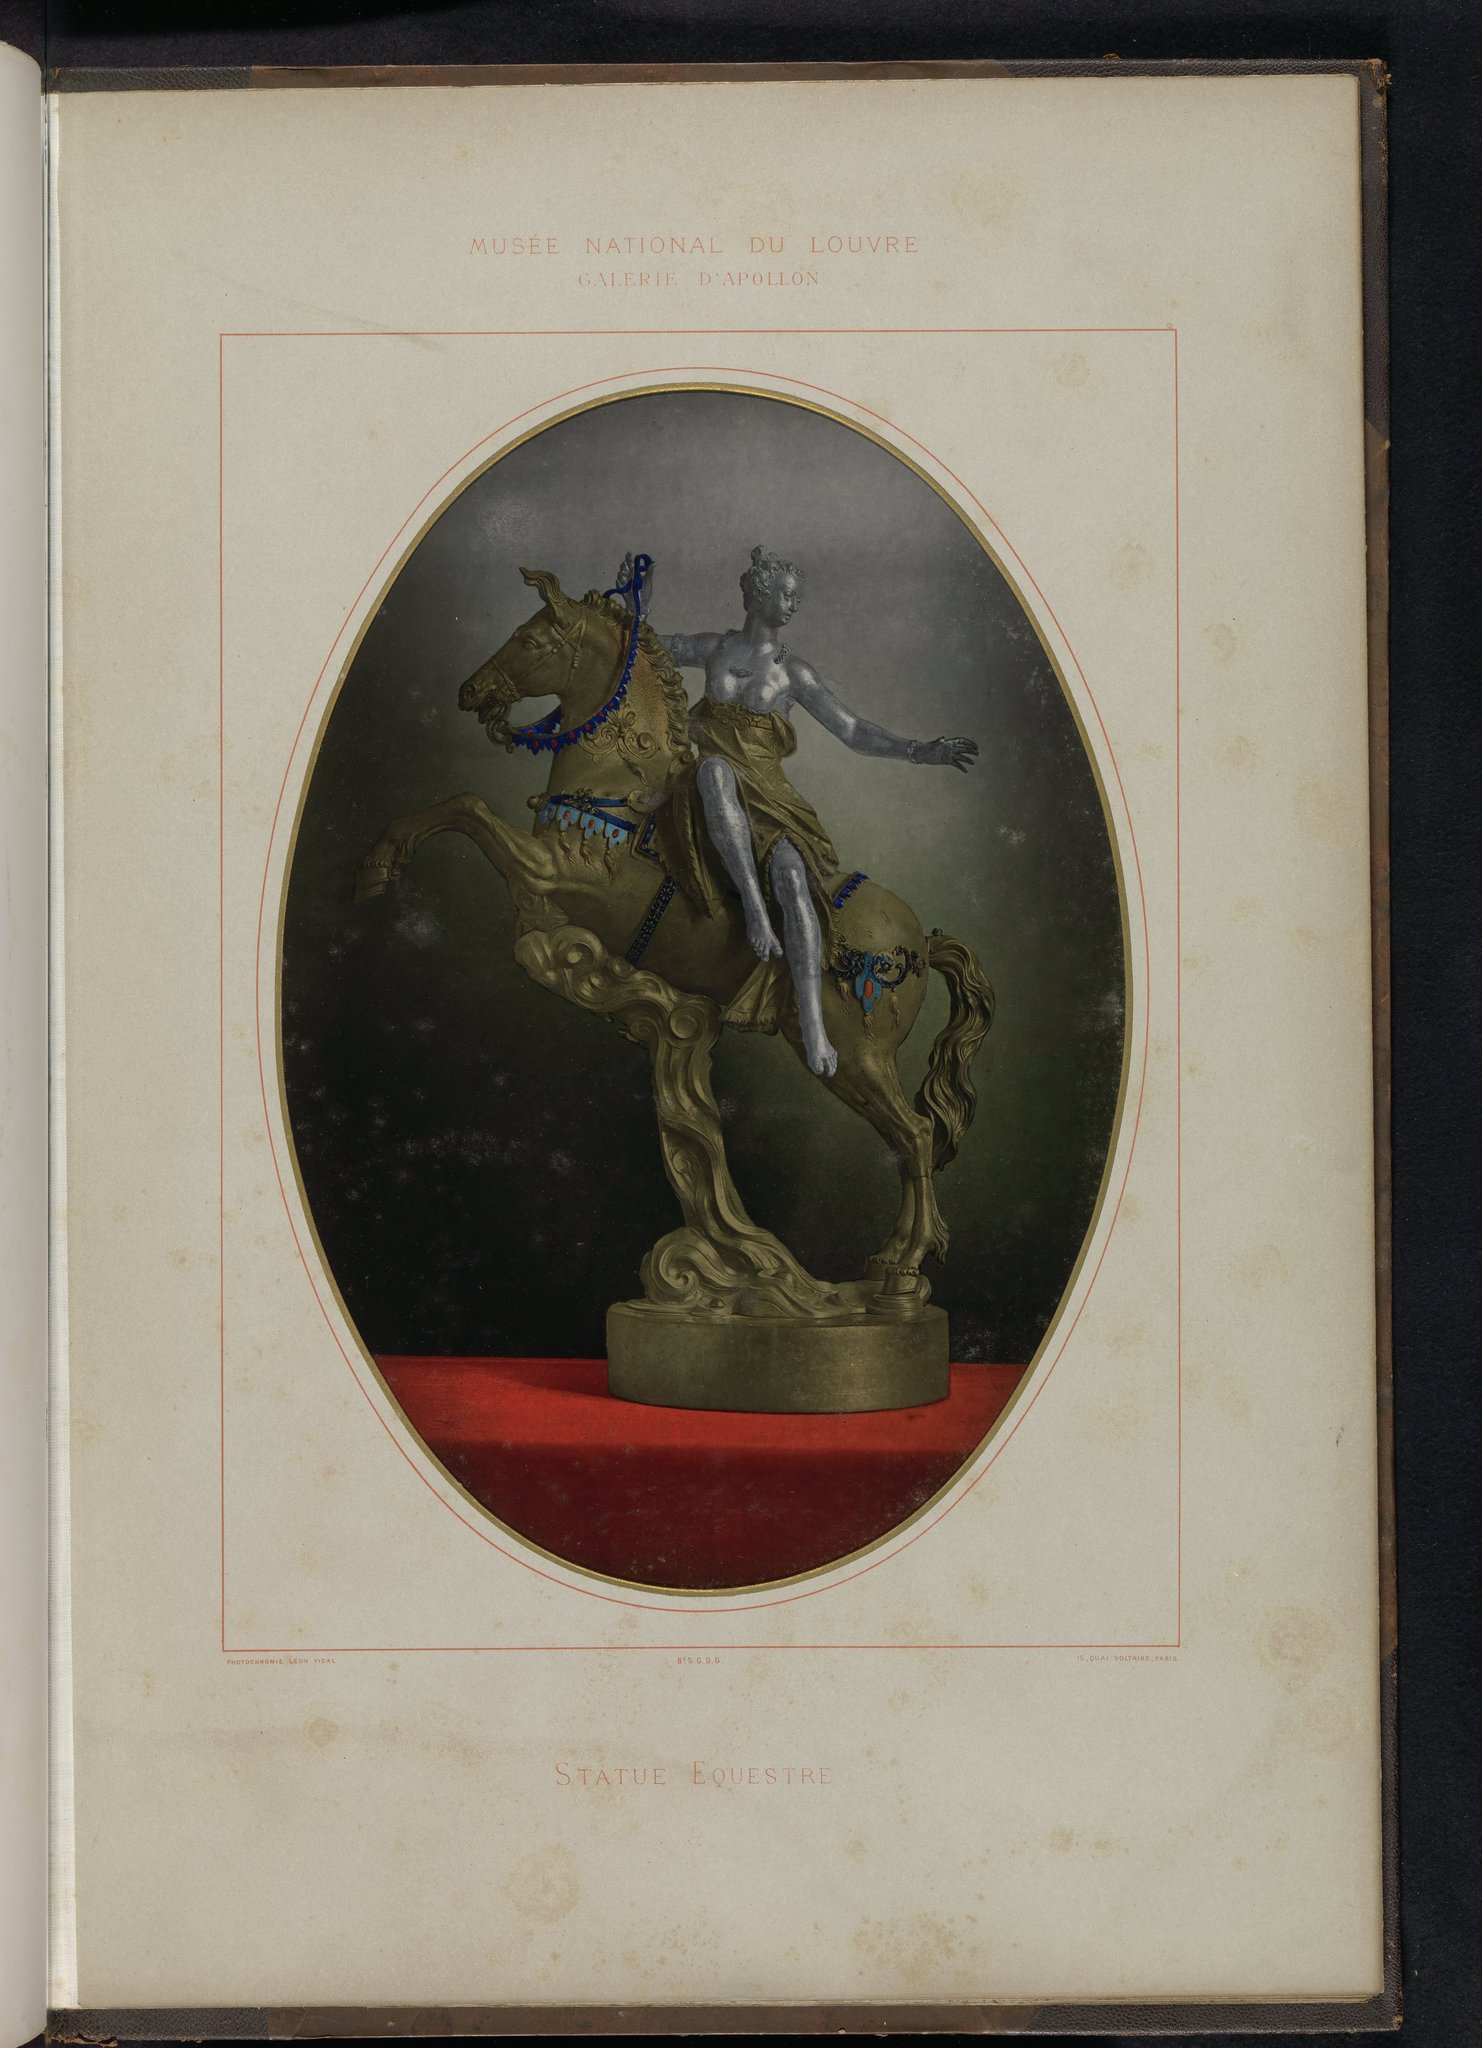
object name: photomechanical print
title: Statue equestre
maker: léon vidal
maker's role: fotograaf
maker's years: 1833-1906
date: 1876-1883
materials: paper, photographic process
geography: paris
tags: equestrian statue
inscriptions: inscription: ‘12e livraison’, inscription: ‘Musée National du Louvre Galerie d'Apollon’, inscription: ‘15 Quai Voltaire. Paris.’